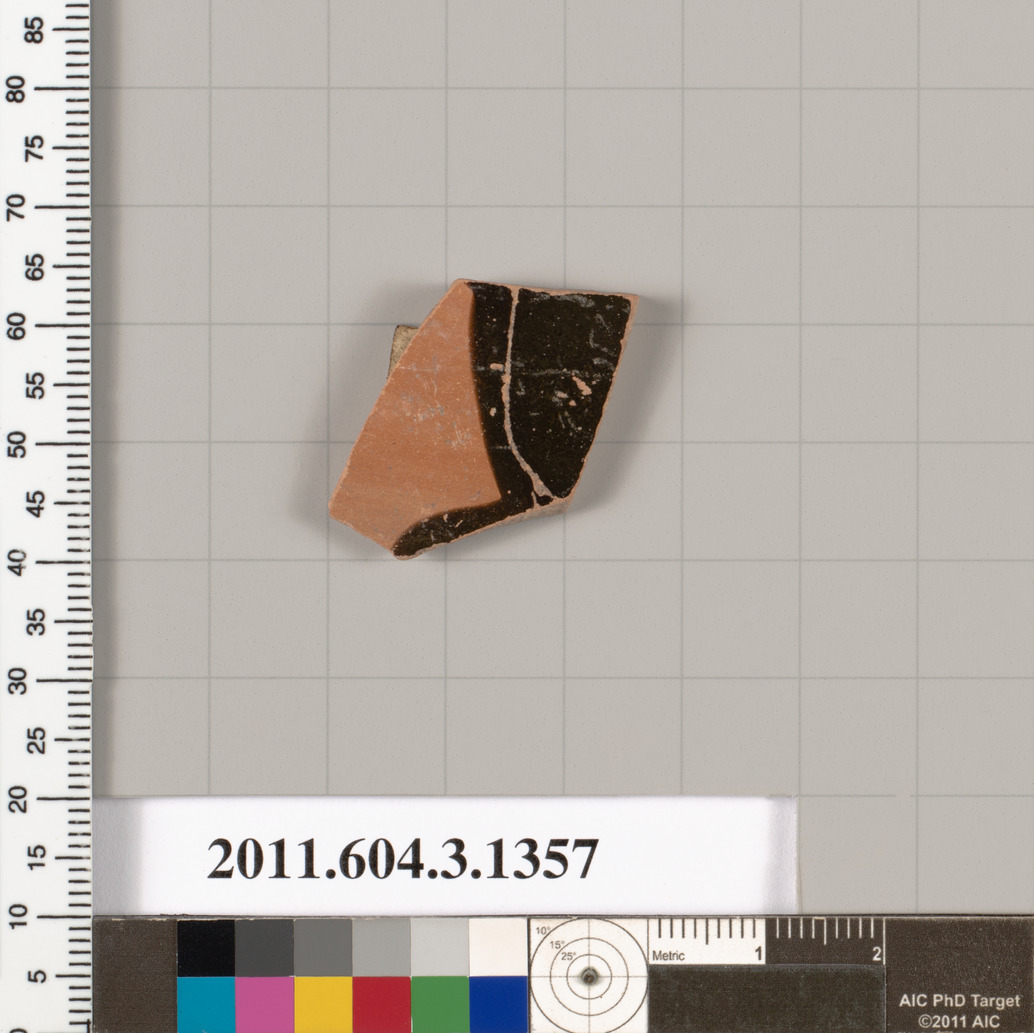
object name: skyphos fragment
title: Terracotta fragment of a skyphos (deep drinking cup)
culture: greek, attic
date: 500-468 BCE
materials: terracotta